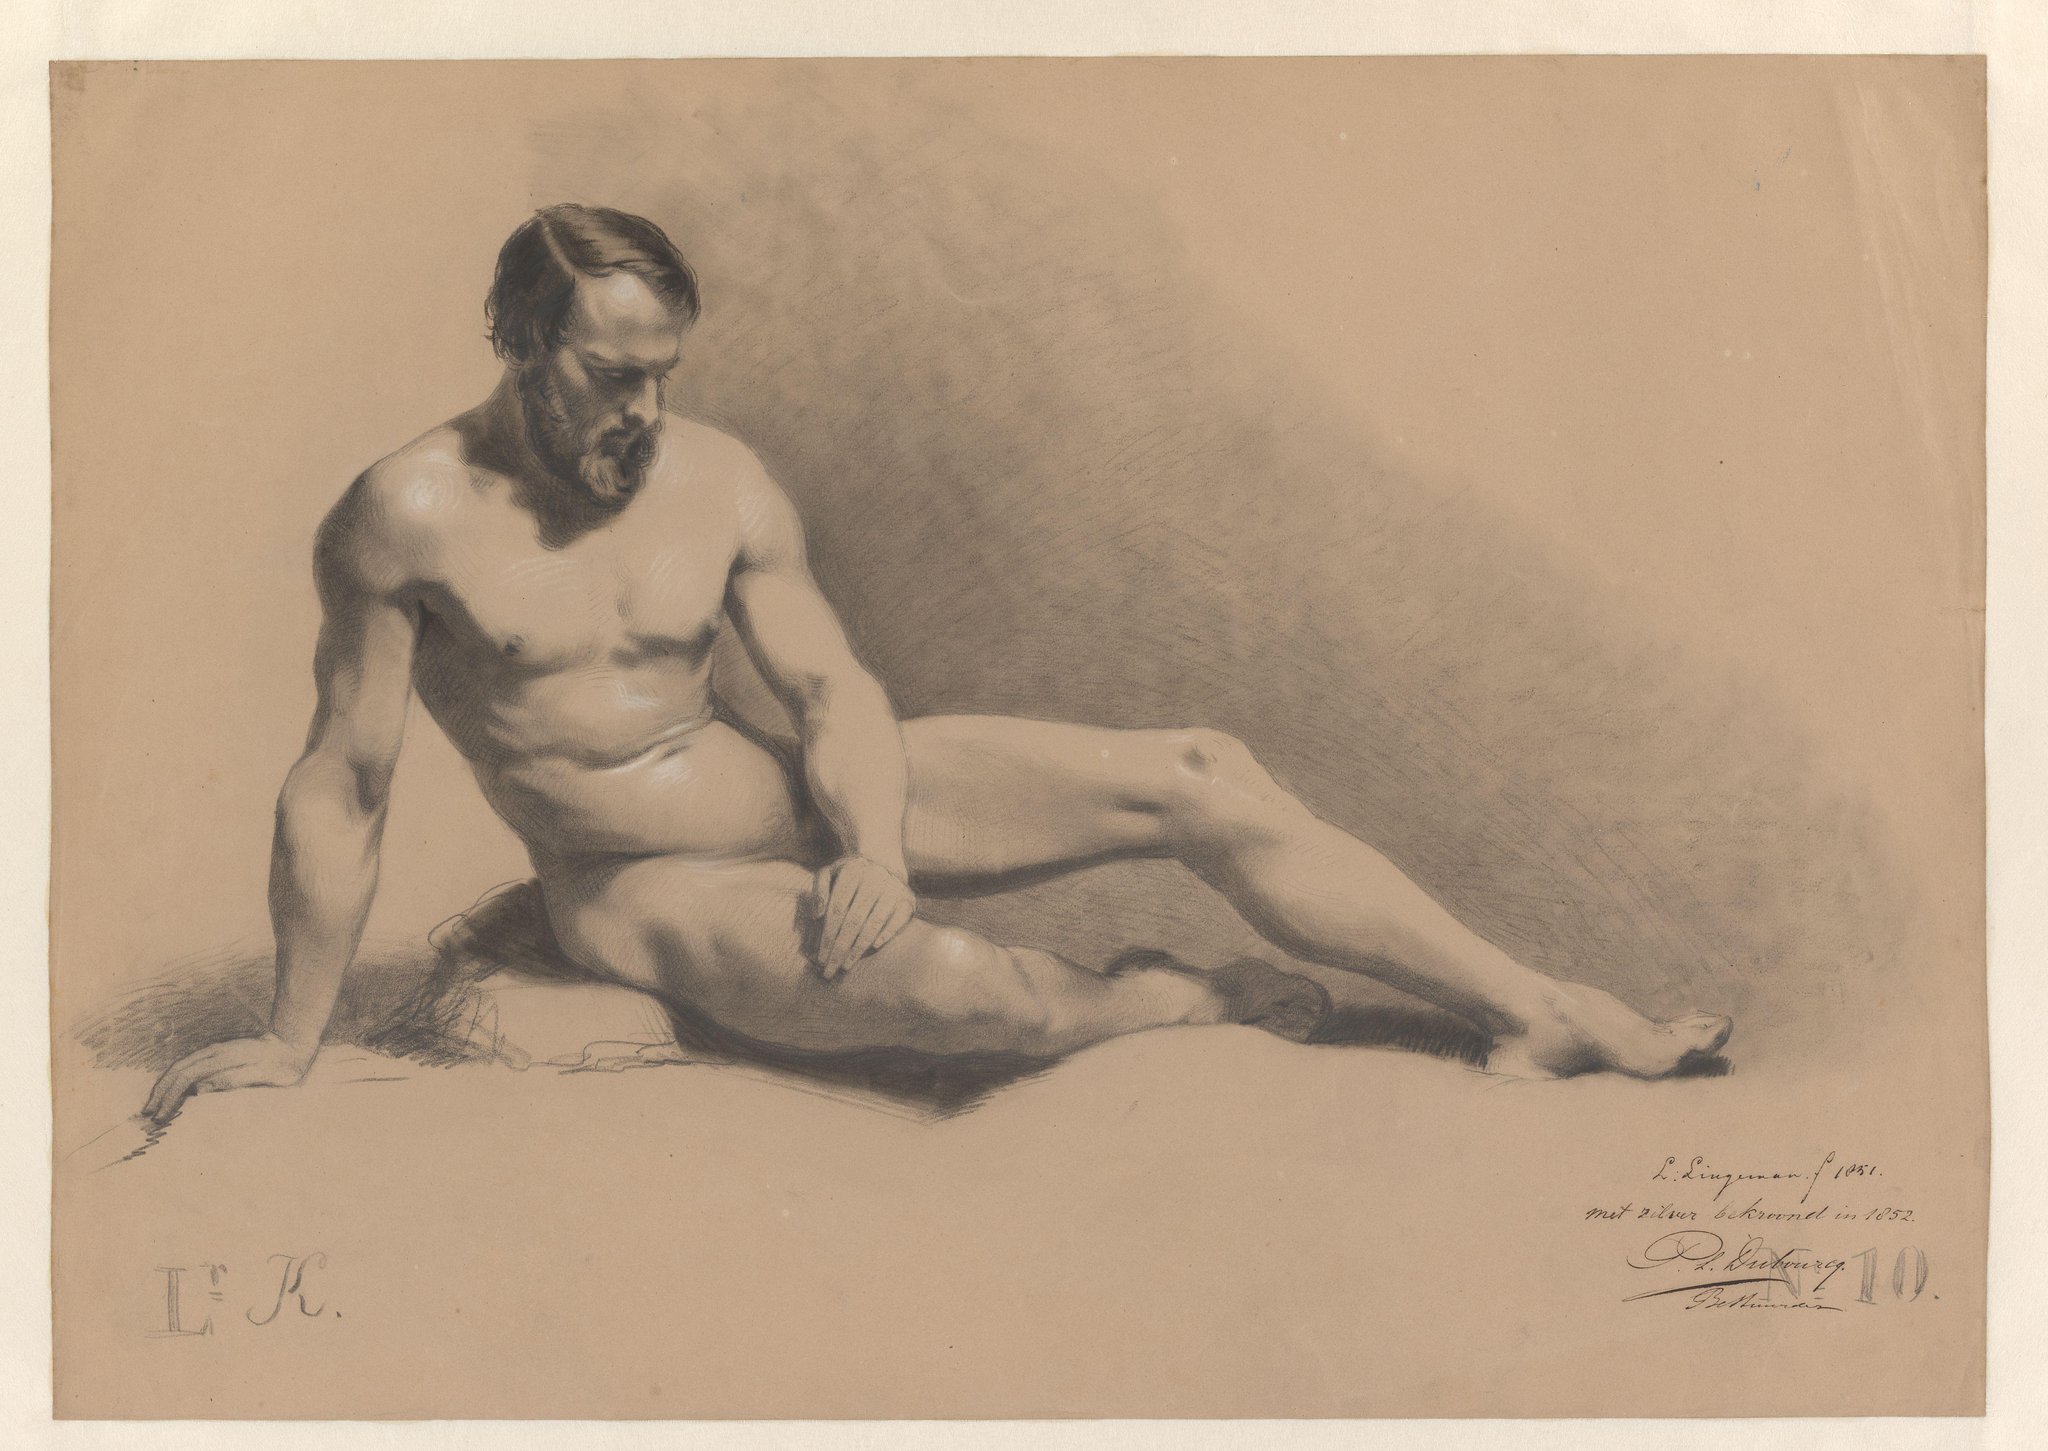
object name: drawing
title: Zittend mannelijk naakt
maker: lambertus lingeman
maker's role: draughtsman, painter, print maker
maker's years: 1829-1894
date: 1851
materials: chalk, paper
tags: sitting figure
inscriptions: date: ‘1851’